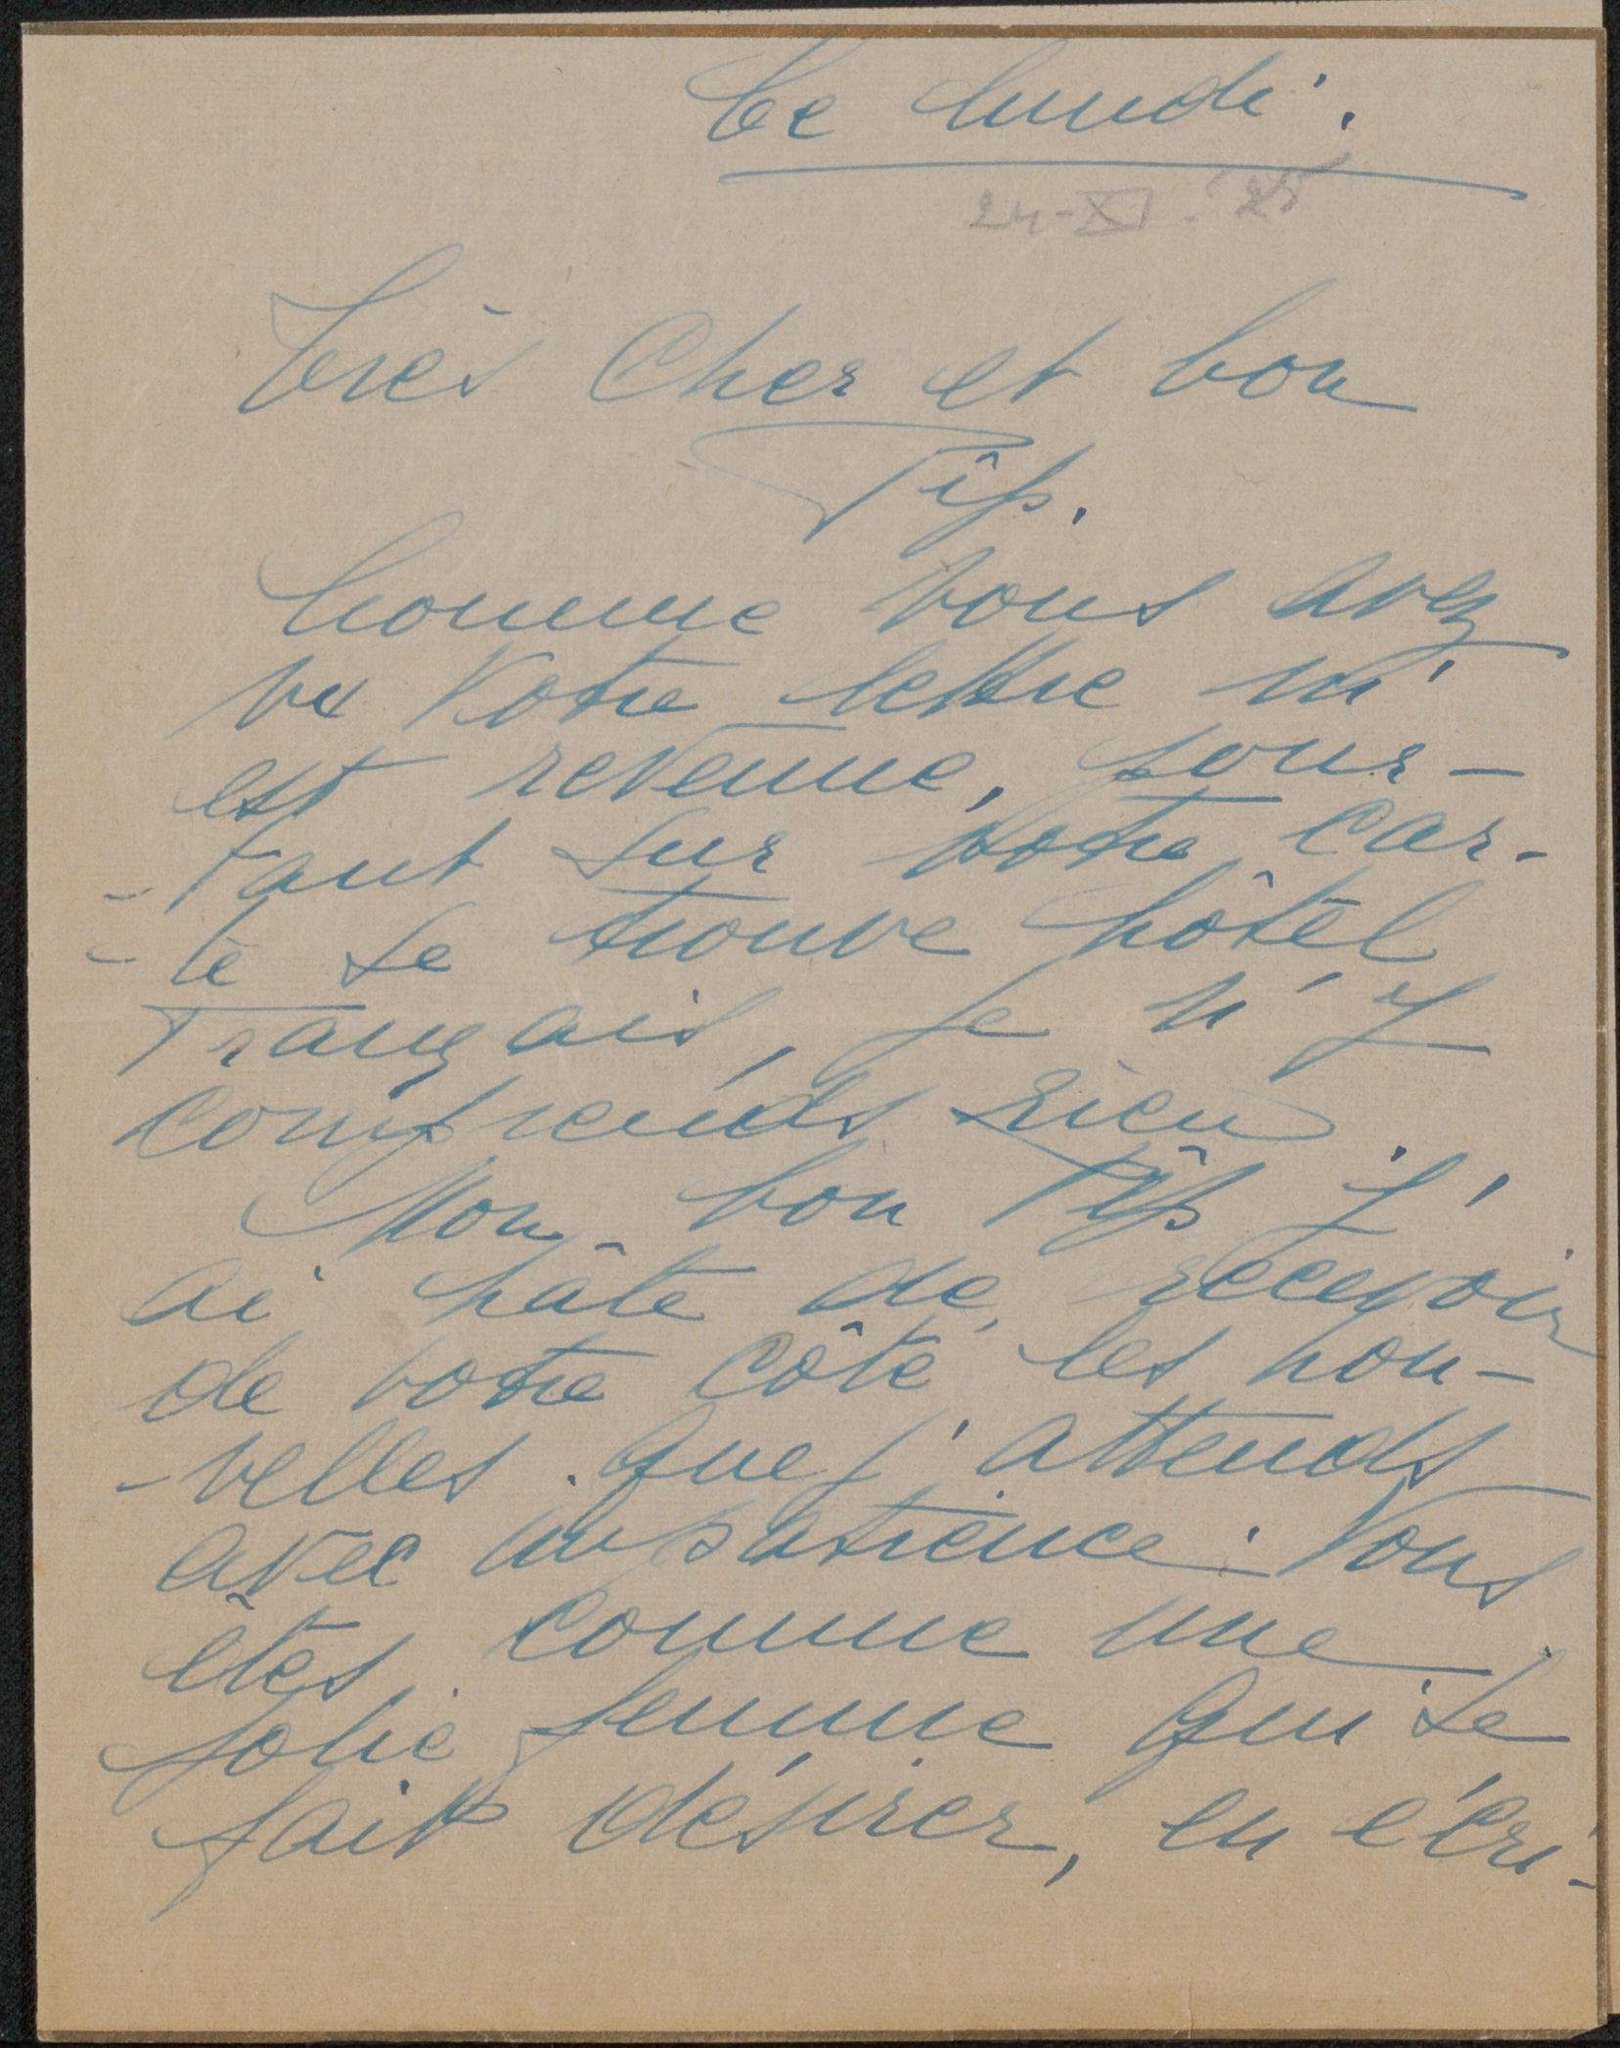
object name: letter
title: Brief aan Philip Zilcken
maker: rose imel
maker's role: draughtsman, painter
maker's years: 1901-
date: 1911-1930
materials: ink, paper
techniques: pen, writing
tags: paris, georges scott, the hague, philip zilcken, drawing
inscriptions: collector's mark: ‘RPK’